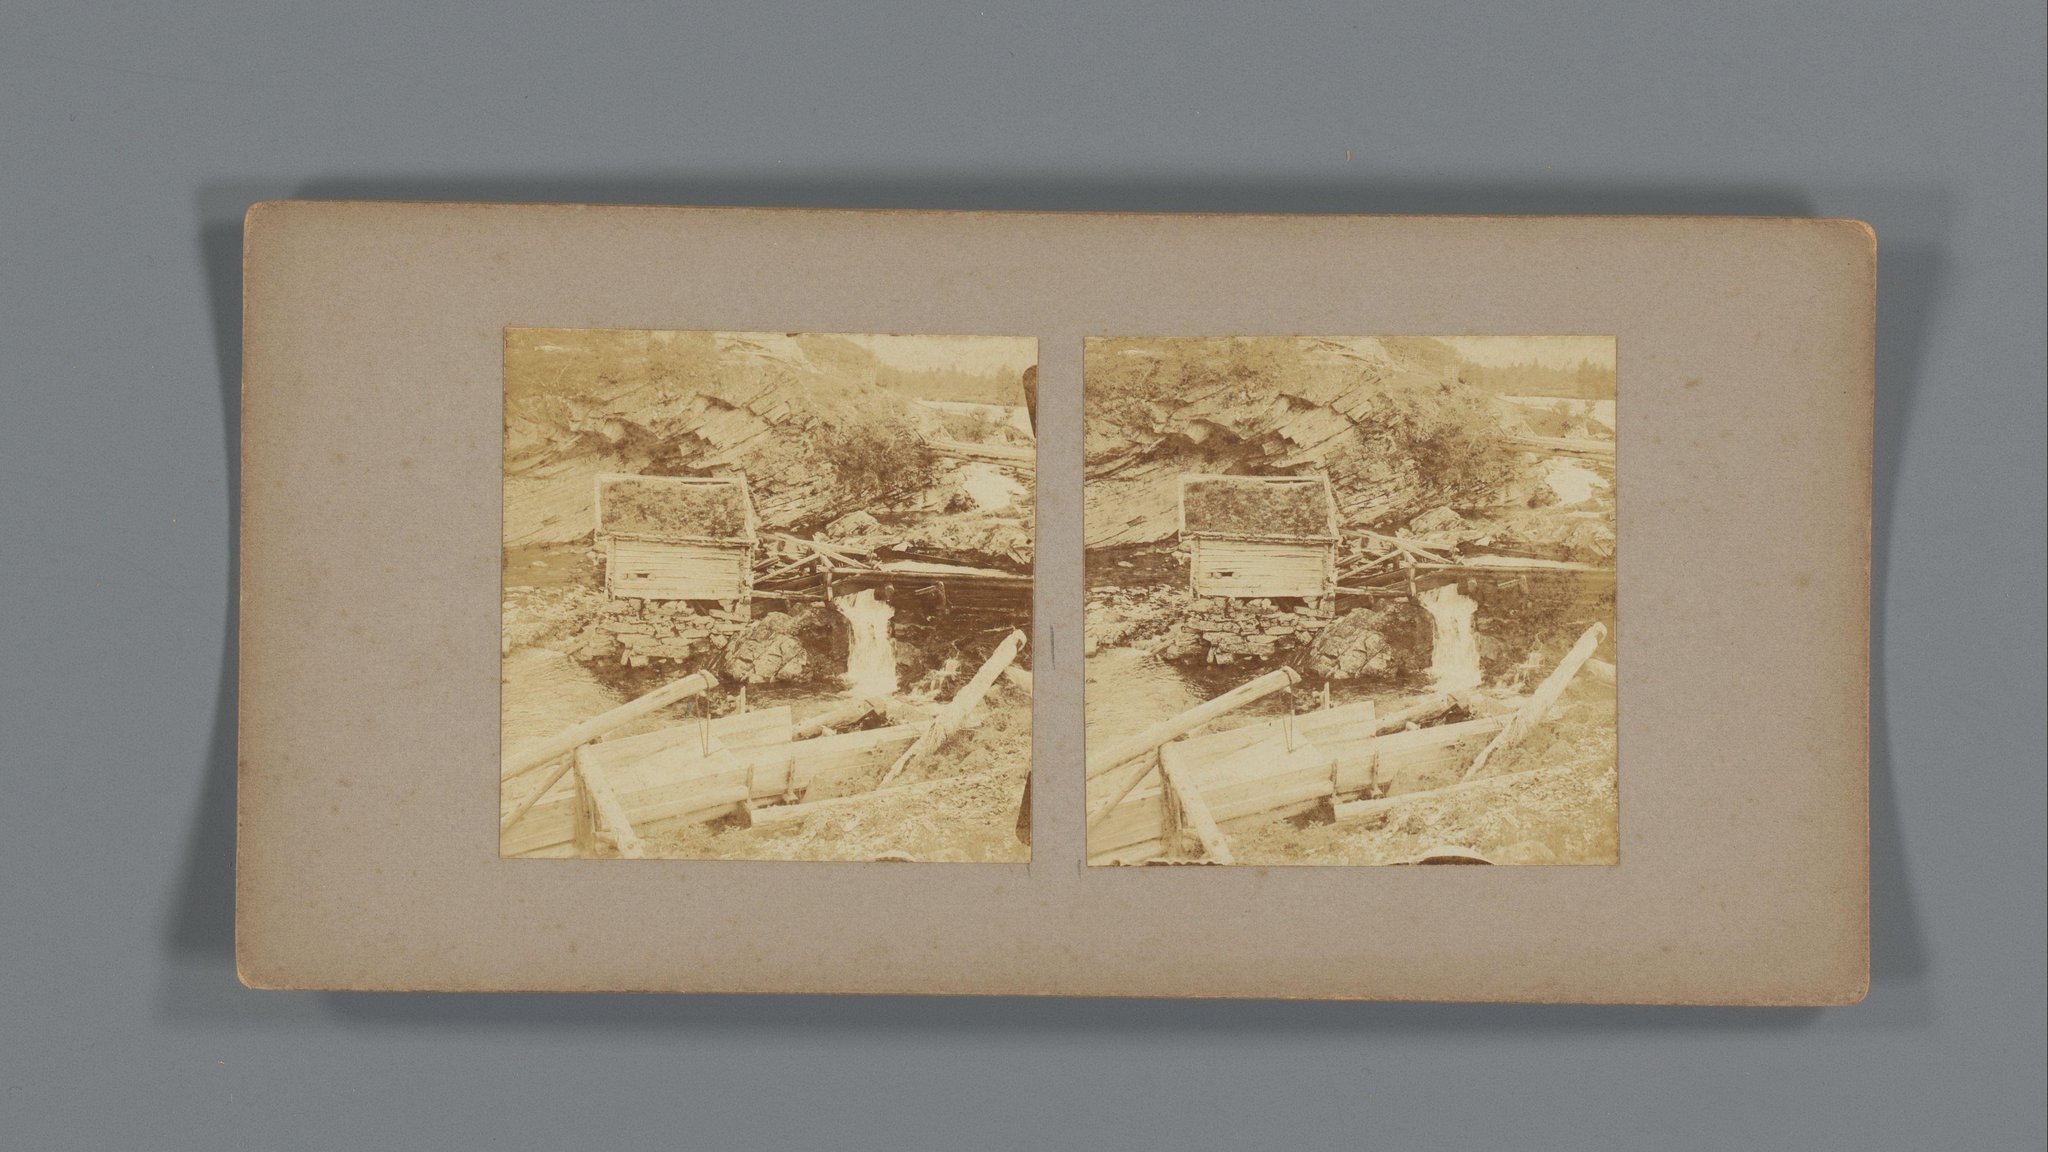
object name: stereograph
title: Huis en een dam in Nærødalen, Noorwegen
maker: Anonymous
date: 1882-1890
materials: cardboard, photographic support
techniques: gelatin silver print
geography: sogn og fjordane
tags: sham-buildings